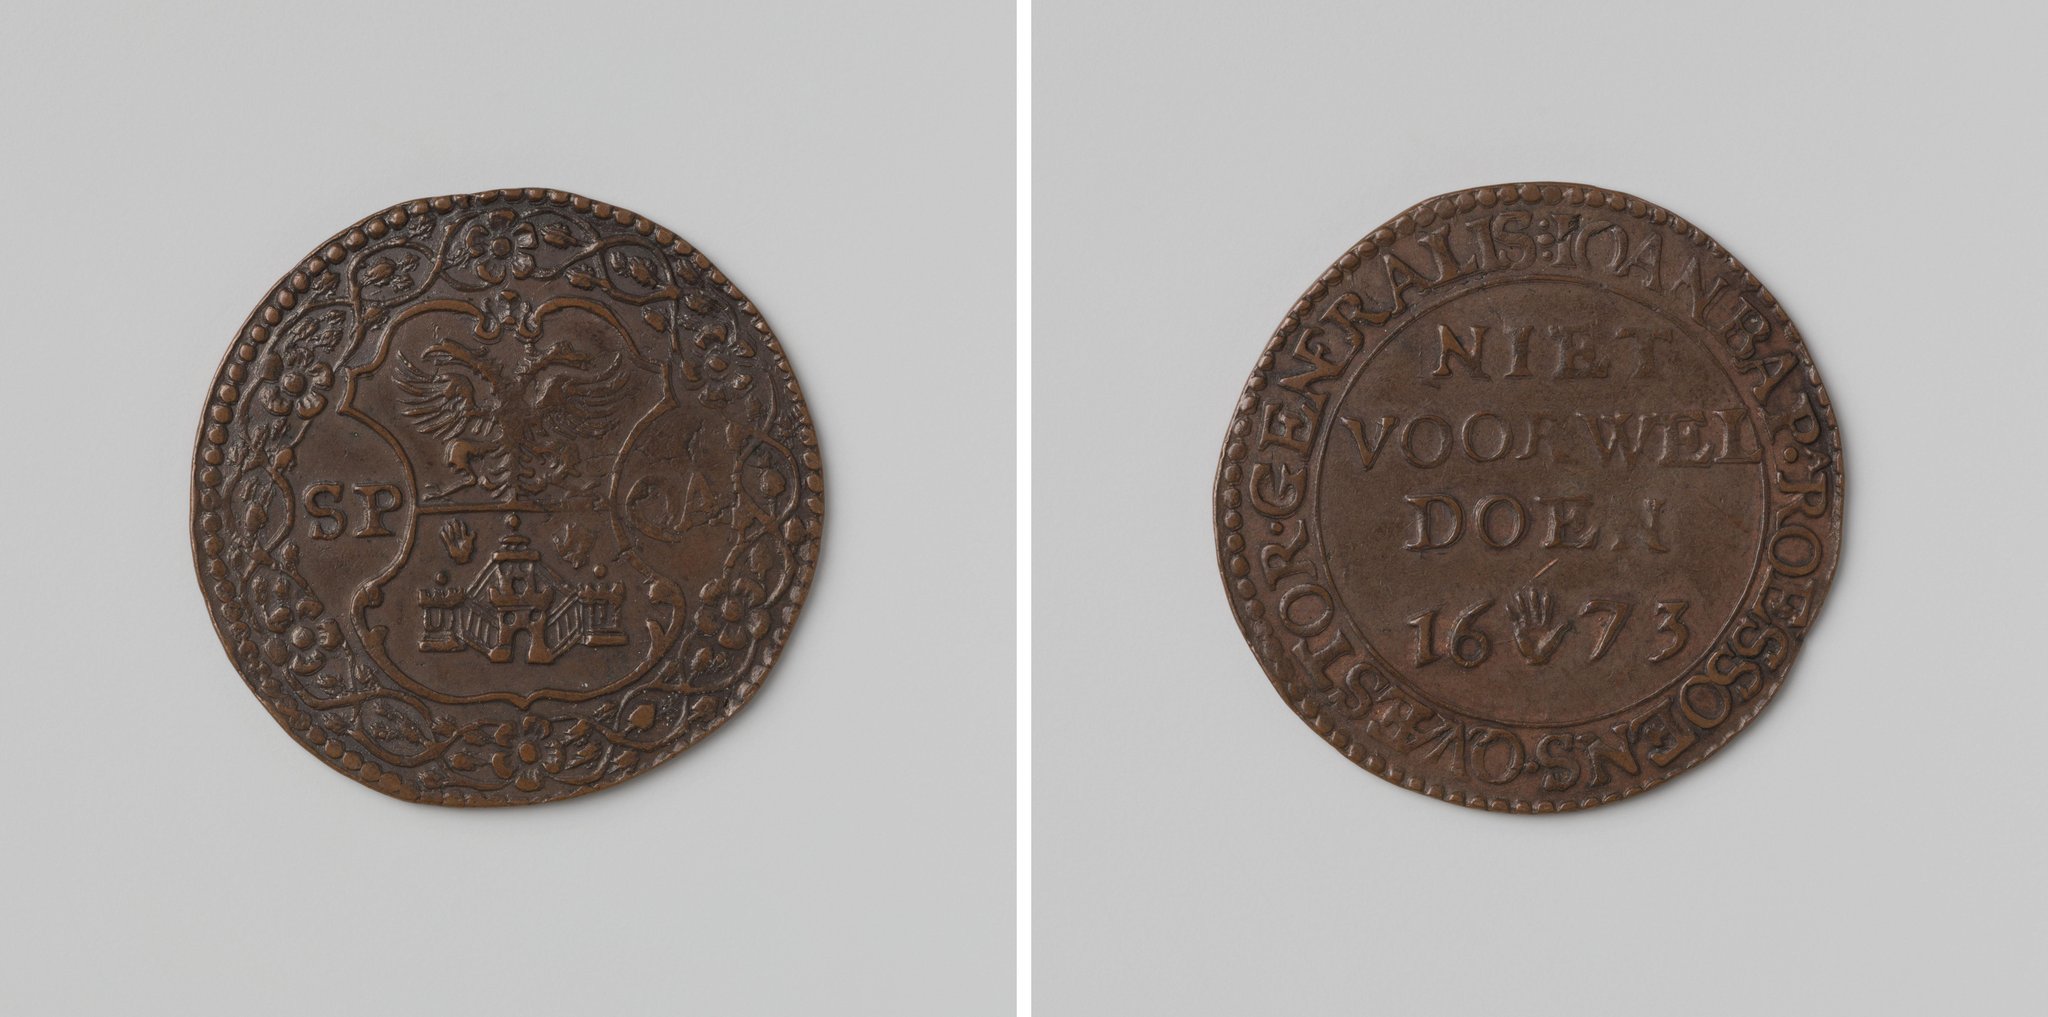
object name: jeton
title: Joan Baptist Roessoens, rentmeester-generaal van de stad Antwerpen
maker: Anonymous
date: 1673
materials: copper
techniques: striking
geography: antwerp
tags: antwerp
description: Koperen penning. Voorzijde: wapenschild in cartouche tussen letters S.P.Q.A. binnen krans van bladeren en bloemen. Keerzijde: opschrift binnen omschrift